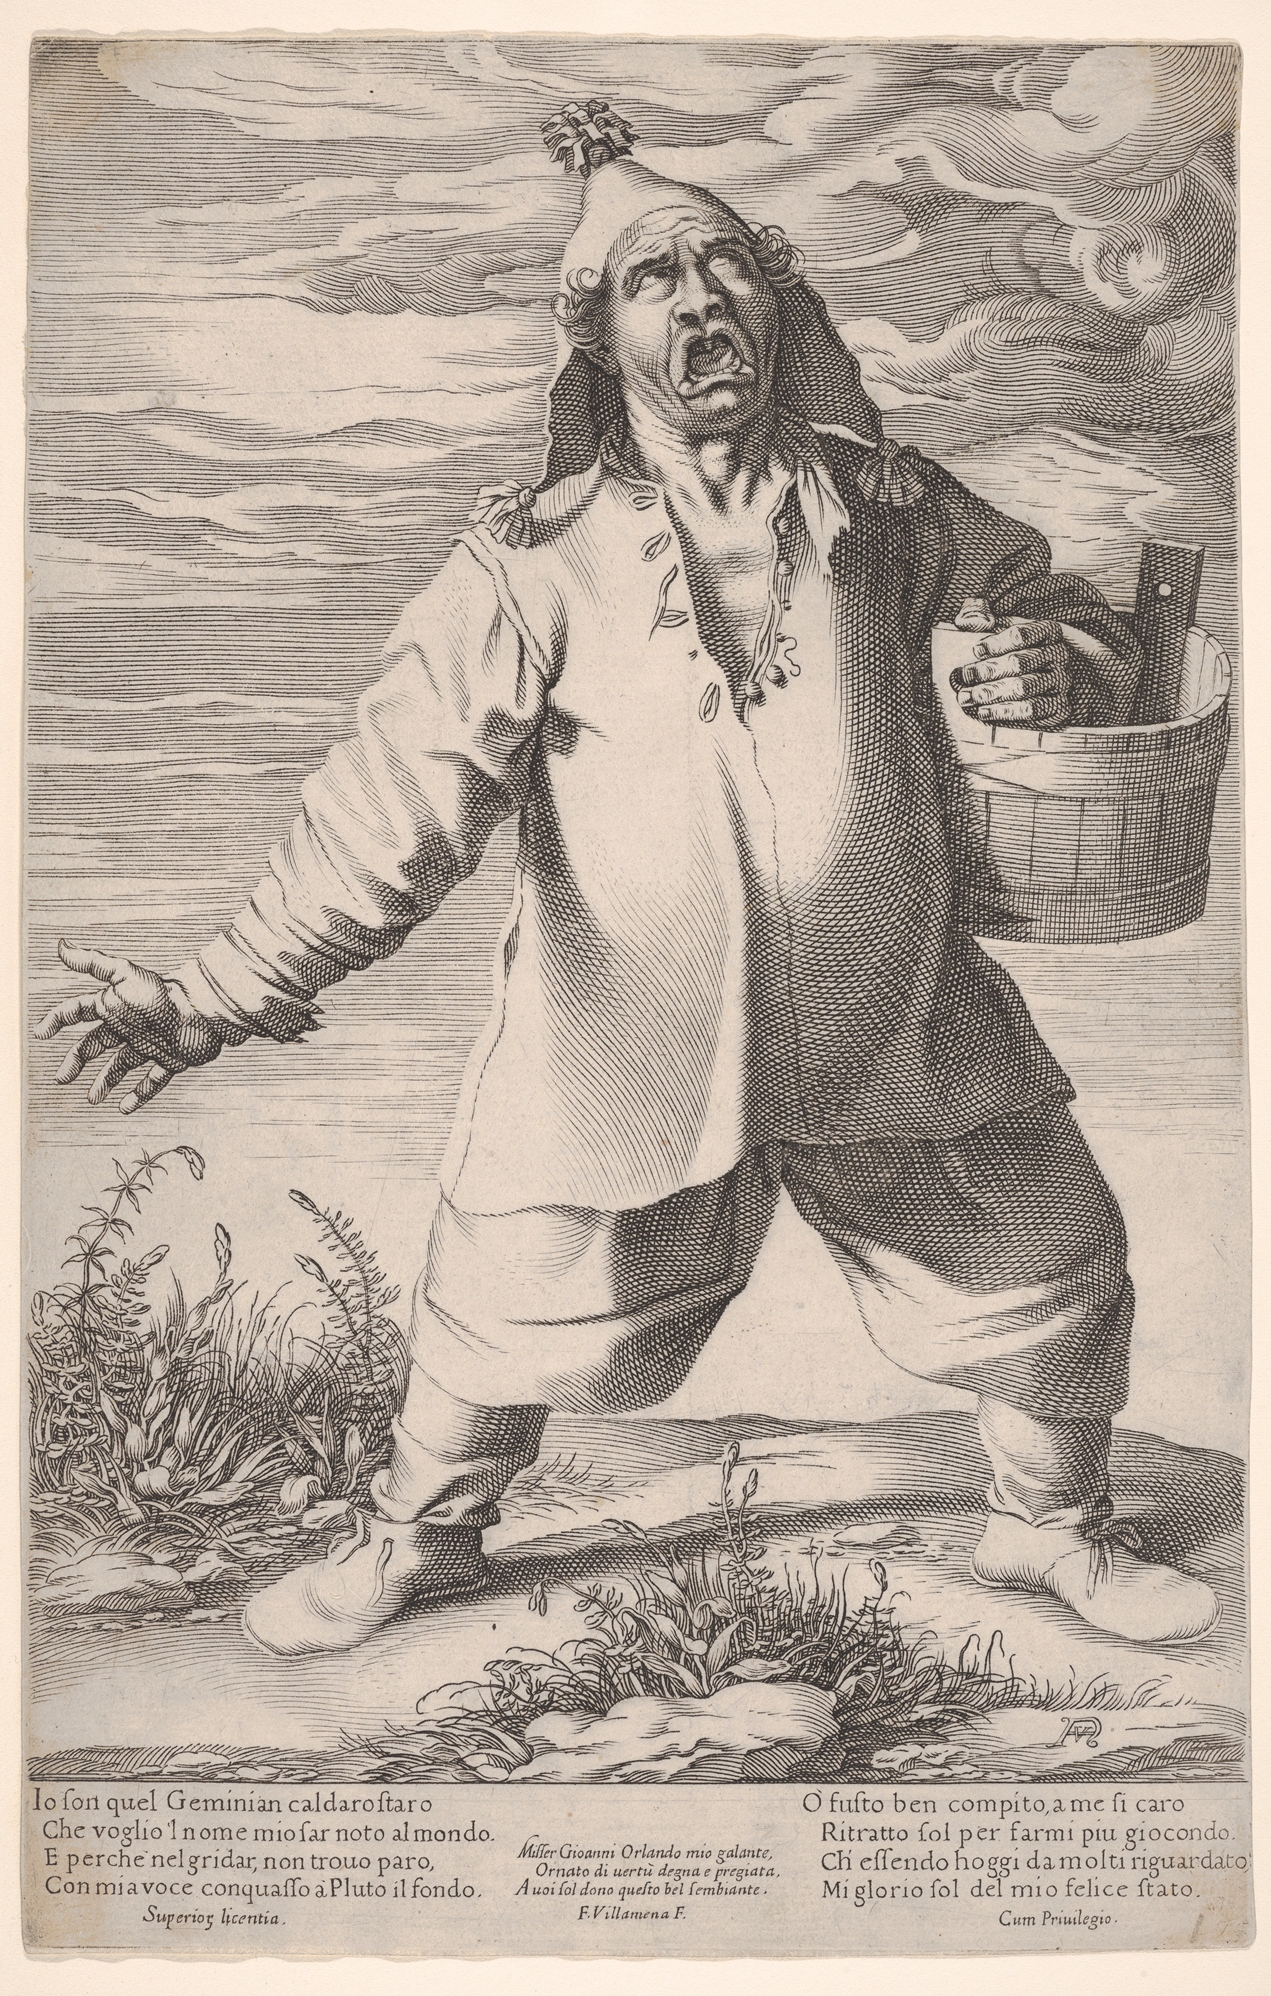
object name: print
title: Geminiano Caldarostaro (chestnut seller)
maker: francesco villamena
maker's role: artist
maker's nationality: italian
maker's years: 1565-1624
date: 1597-1601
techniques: engraving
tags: men